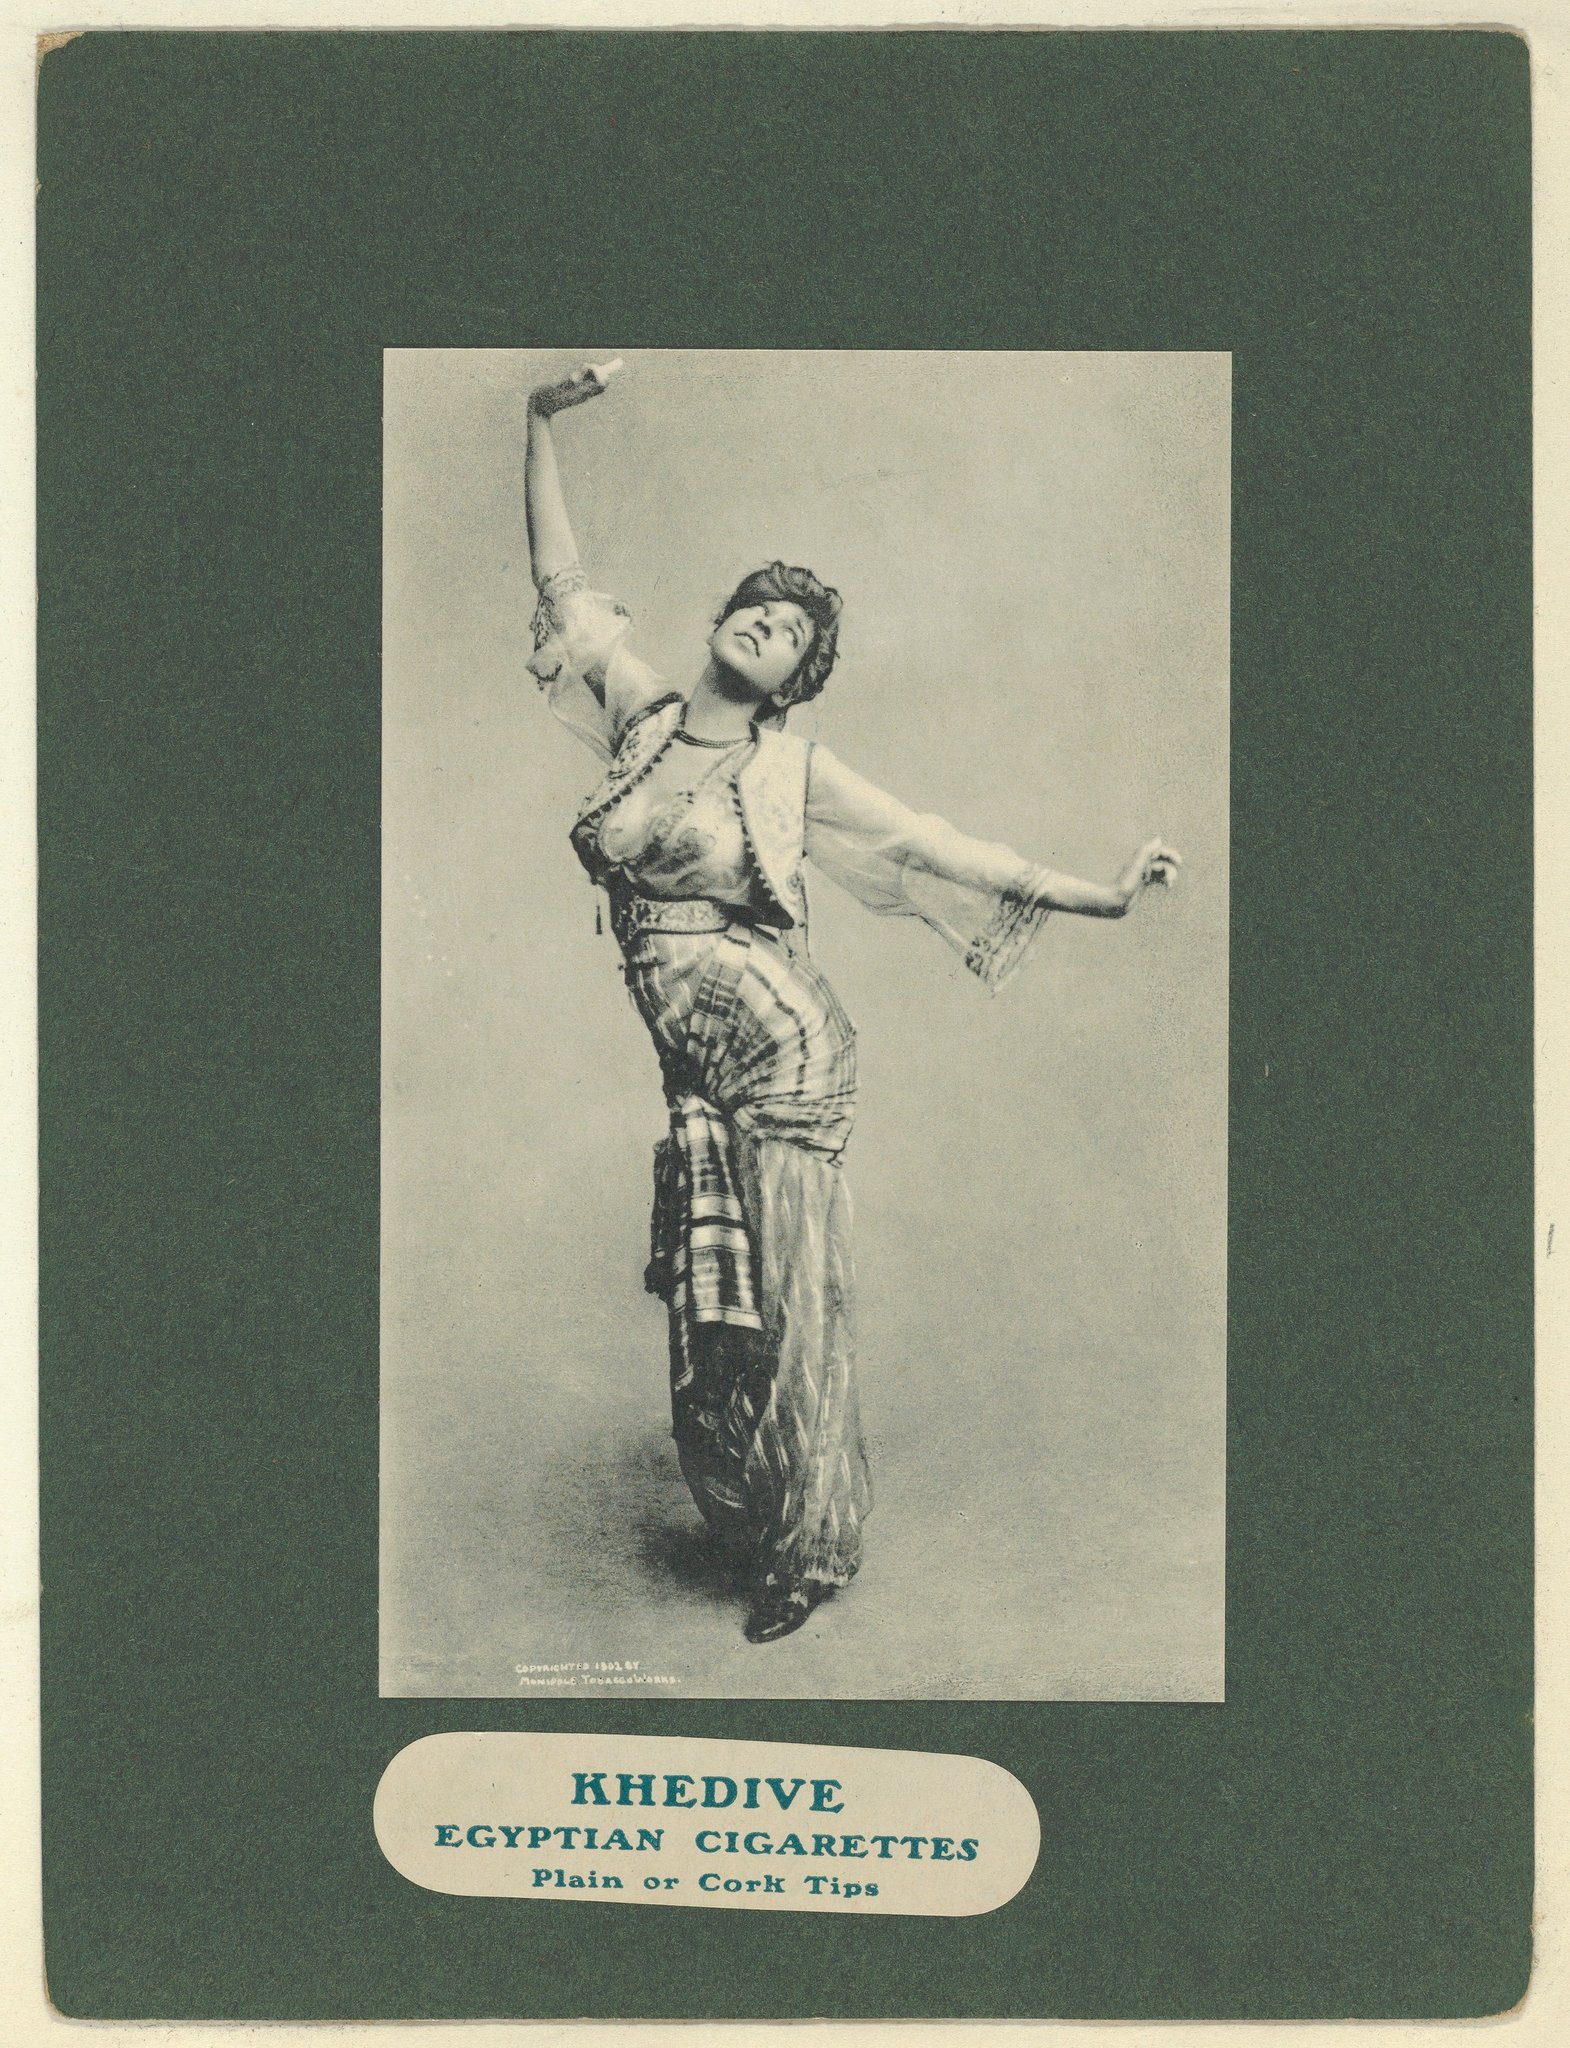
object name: print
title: Plate 4, from Little Egypt Actresses series (T2), issued by Monopole Tobacco Works to promote Khedive Egyptian Cigarettes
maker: monopole tobacco works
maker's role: publisher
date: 1902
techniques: photolithograph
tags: women,actresses